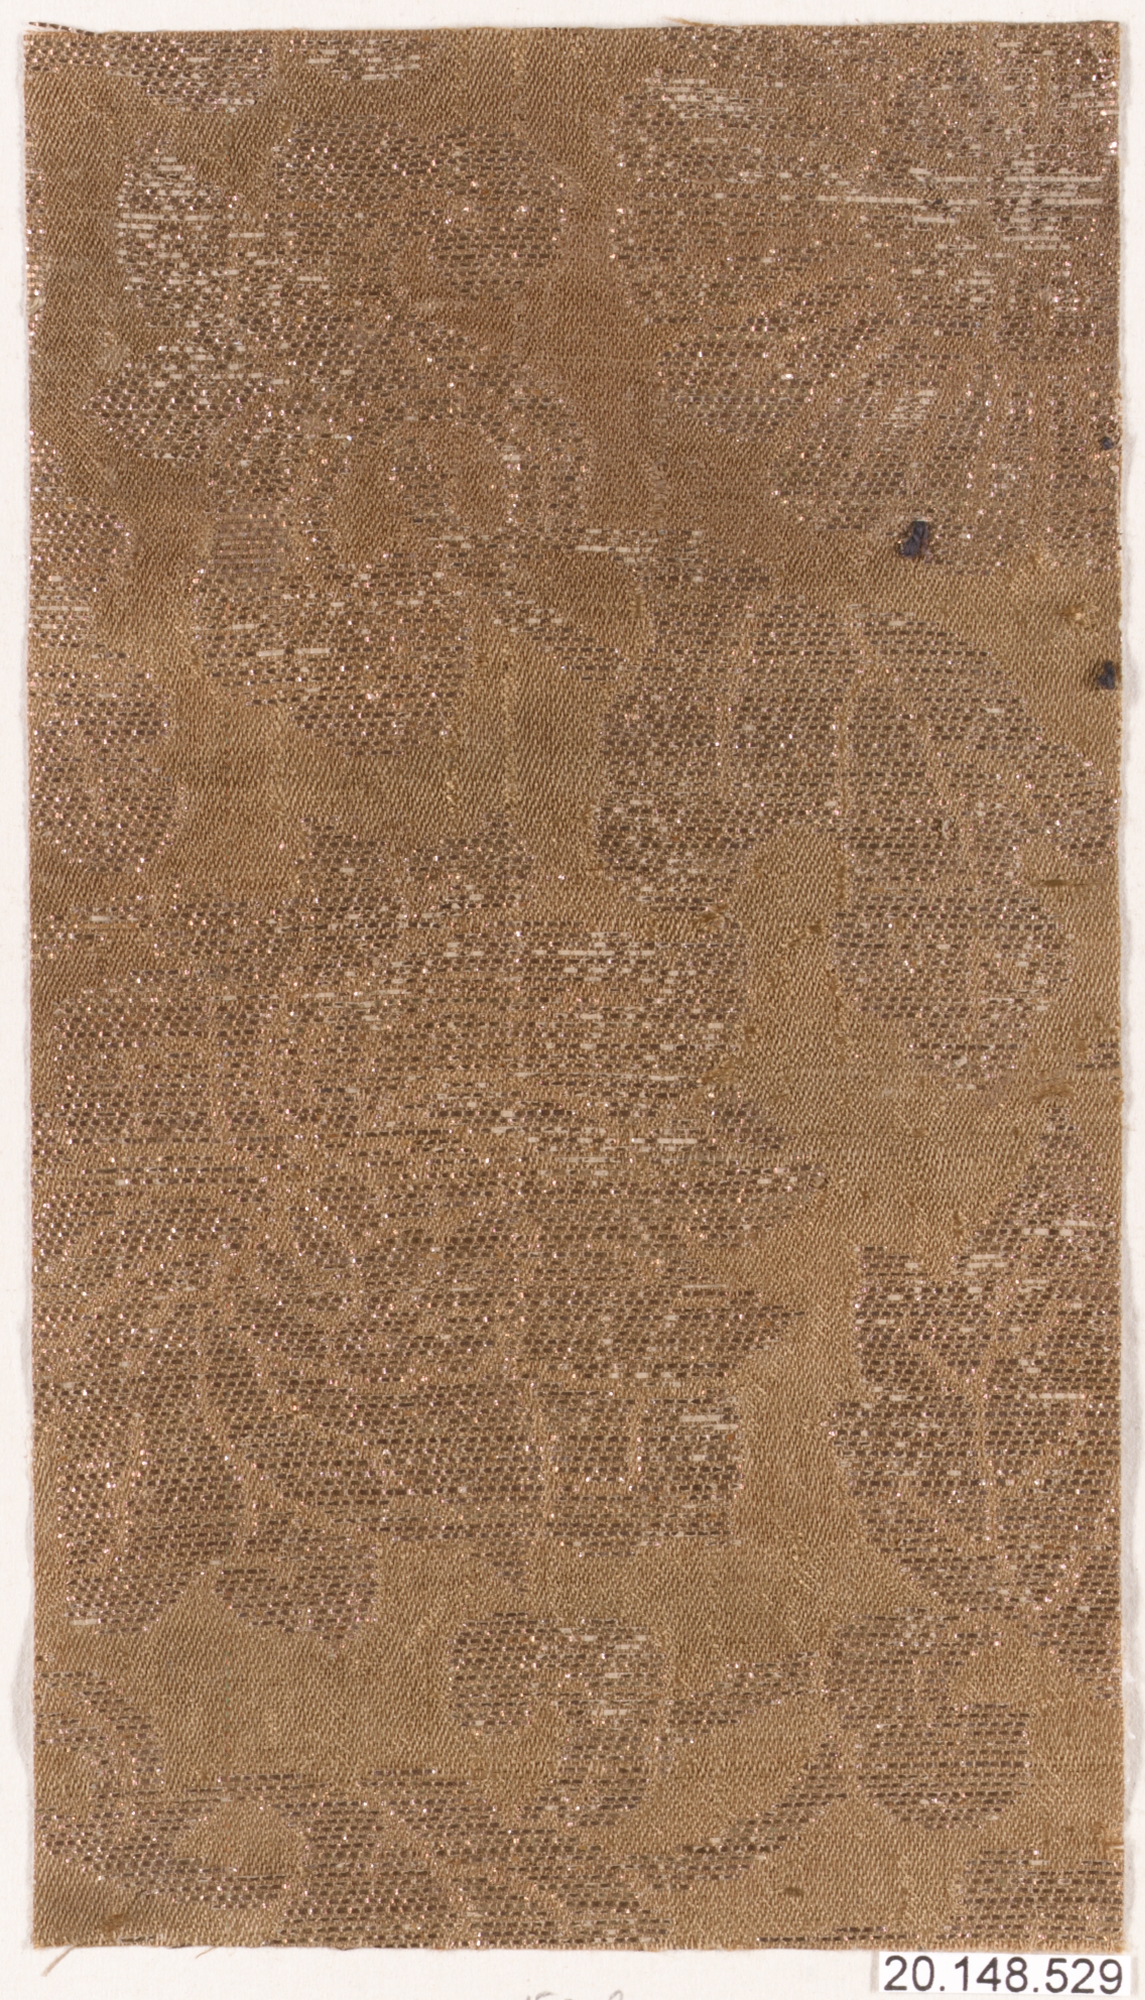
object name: piece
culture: japanese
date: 1601-1700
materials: silk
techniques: compound weave